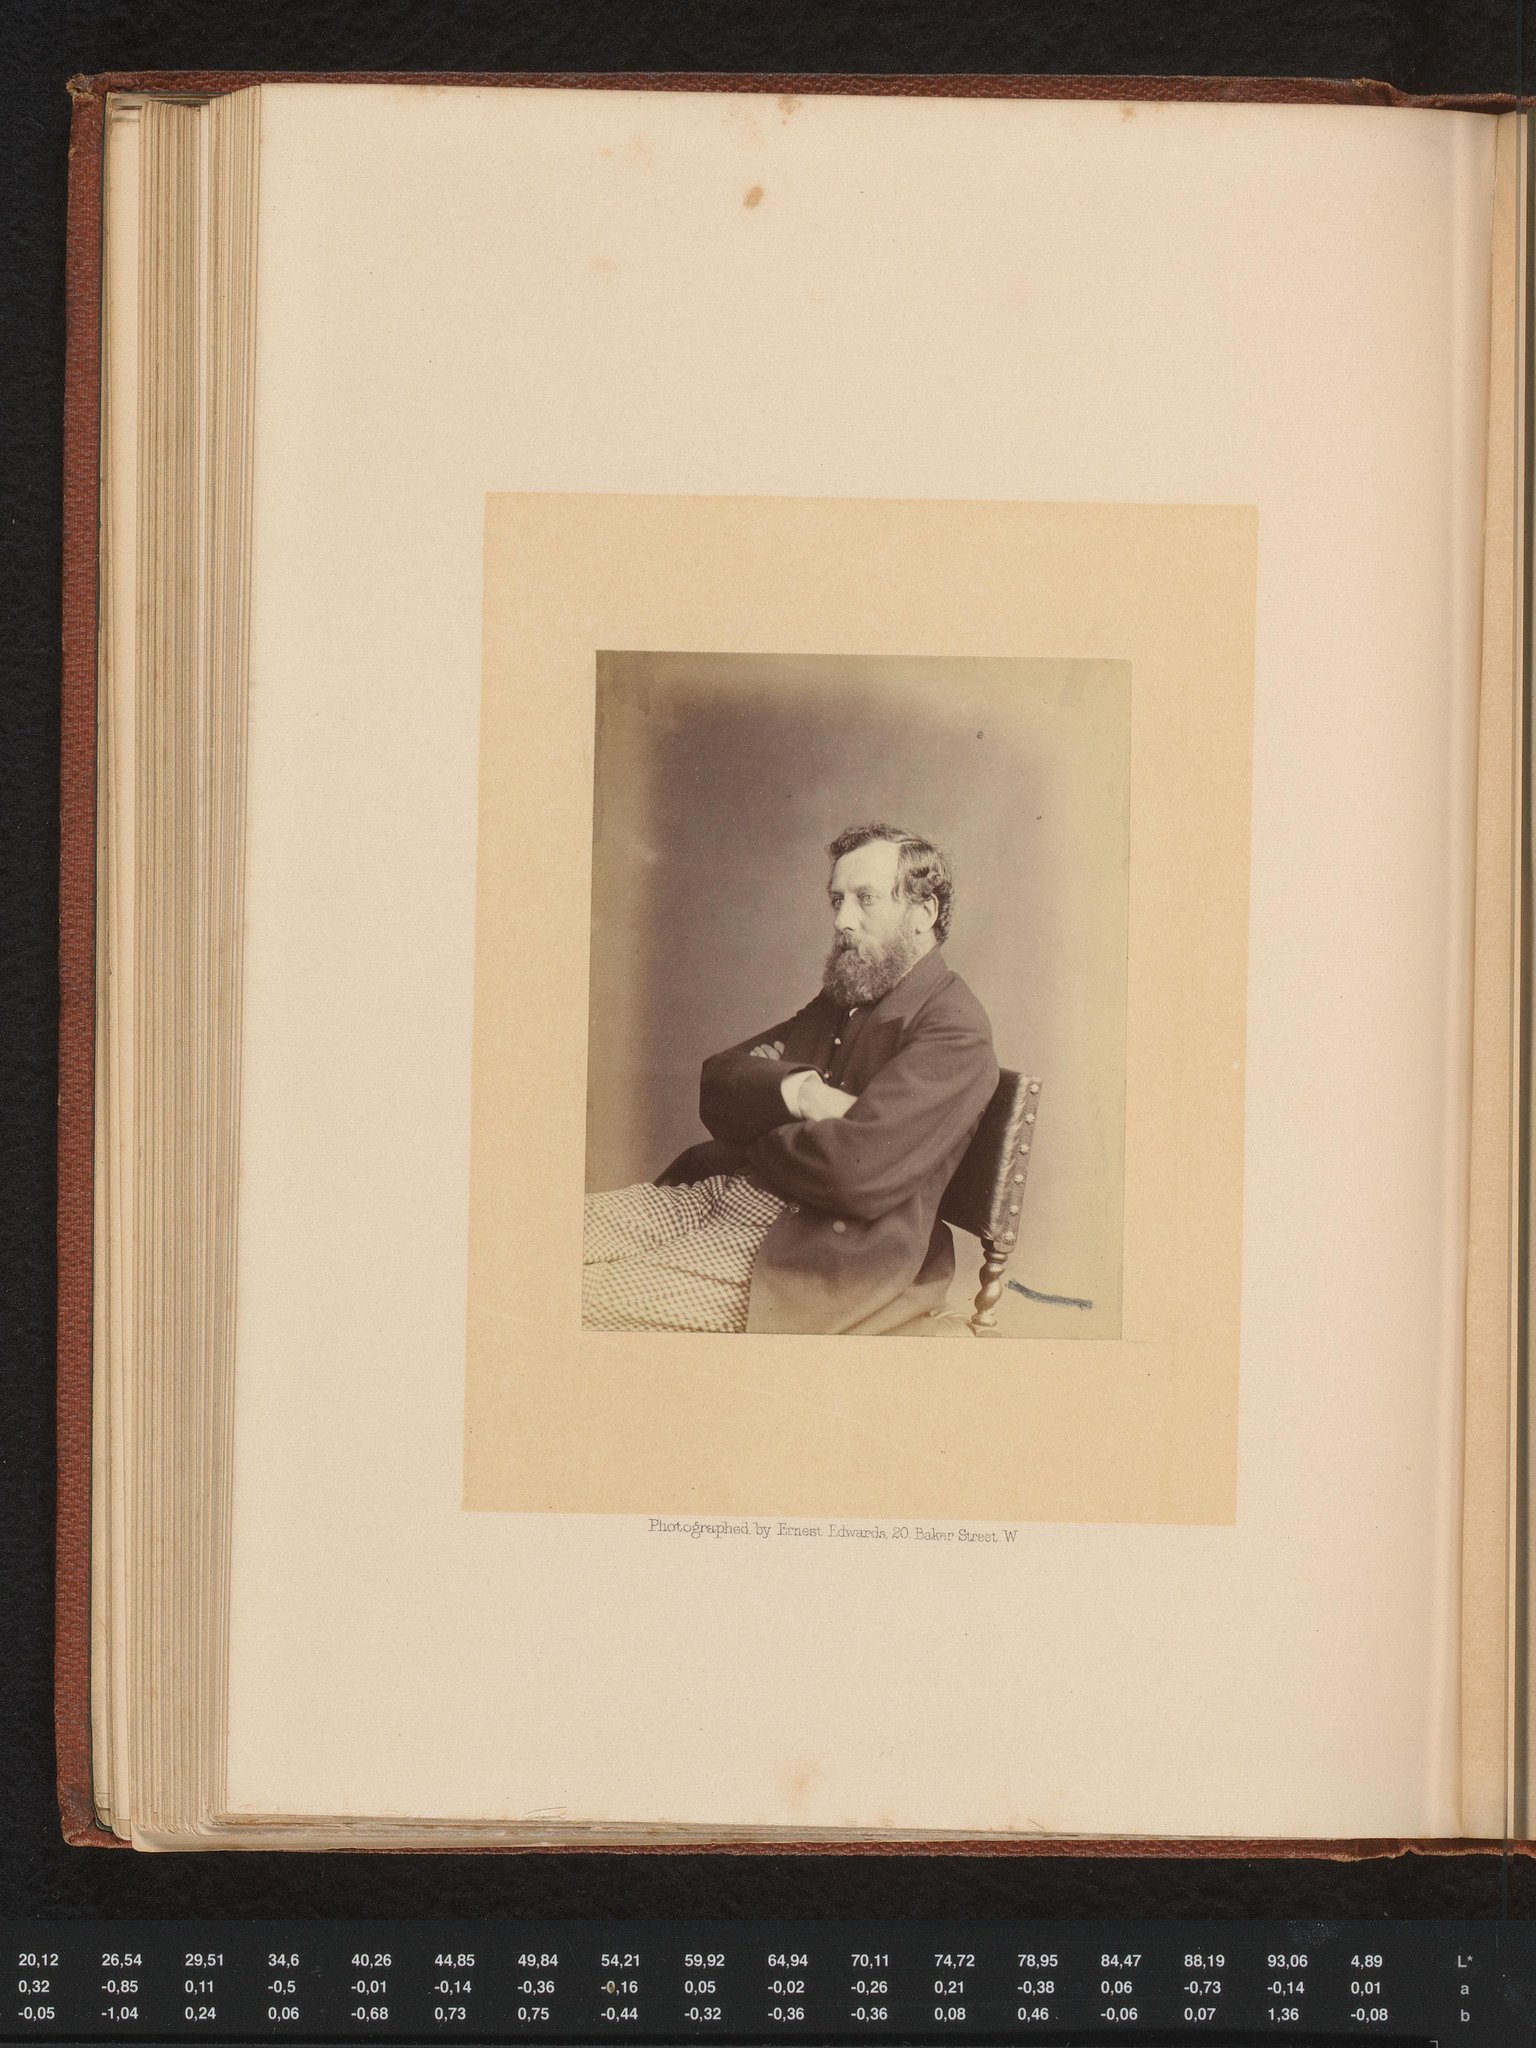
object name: page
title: Portret van de geoloog Andrew Crombie Ramsay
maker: ernest edwards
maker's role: fotograaf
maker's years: 1837-1903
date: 1861-1866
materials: paper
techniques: albumen print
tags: geology (+ portrait of scholar, scientist)